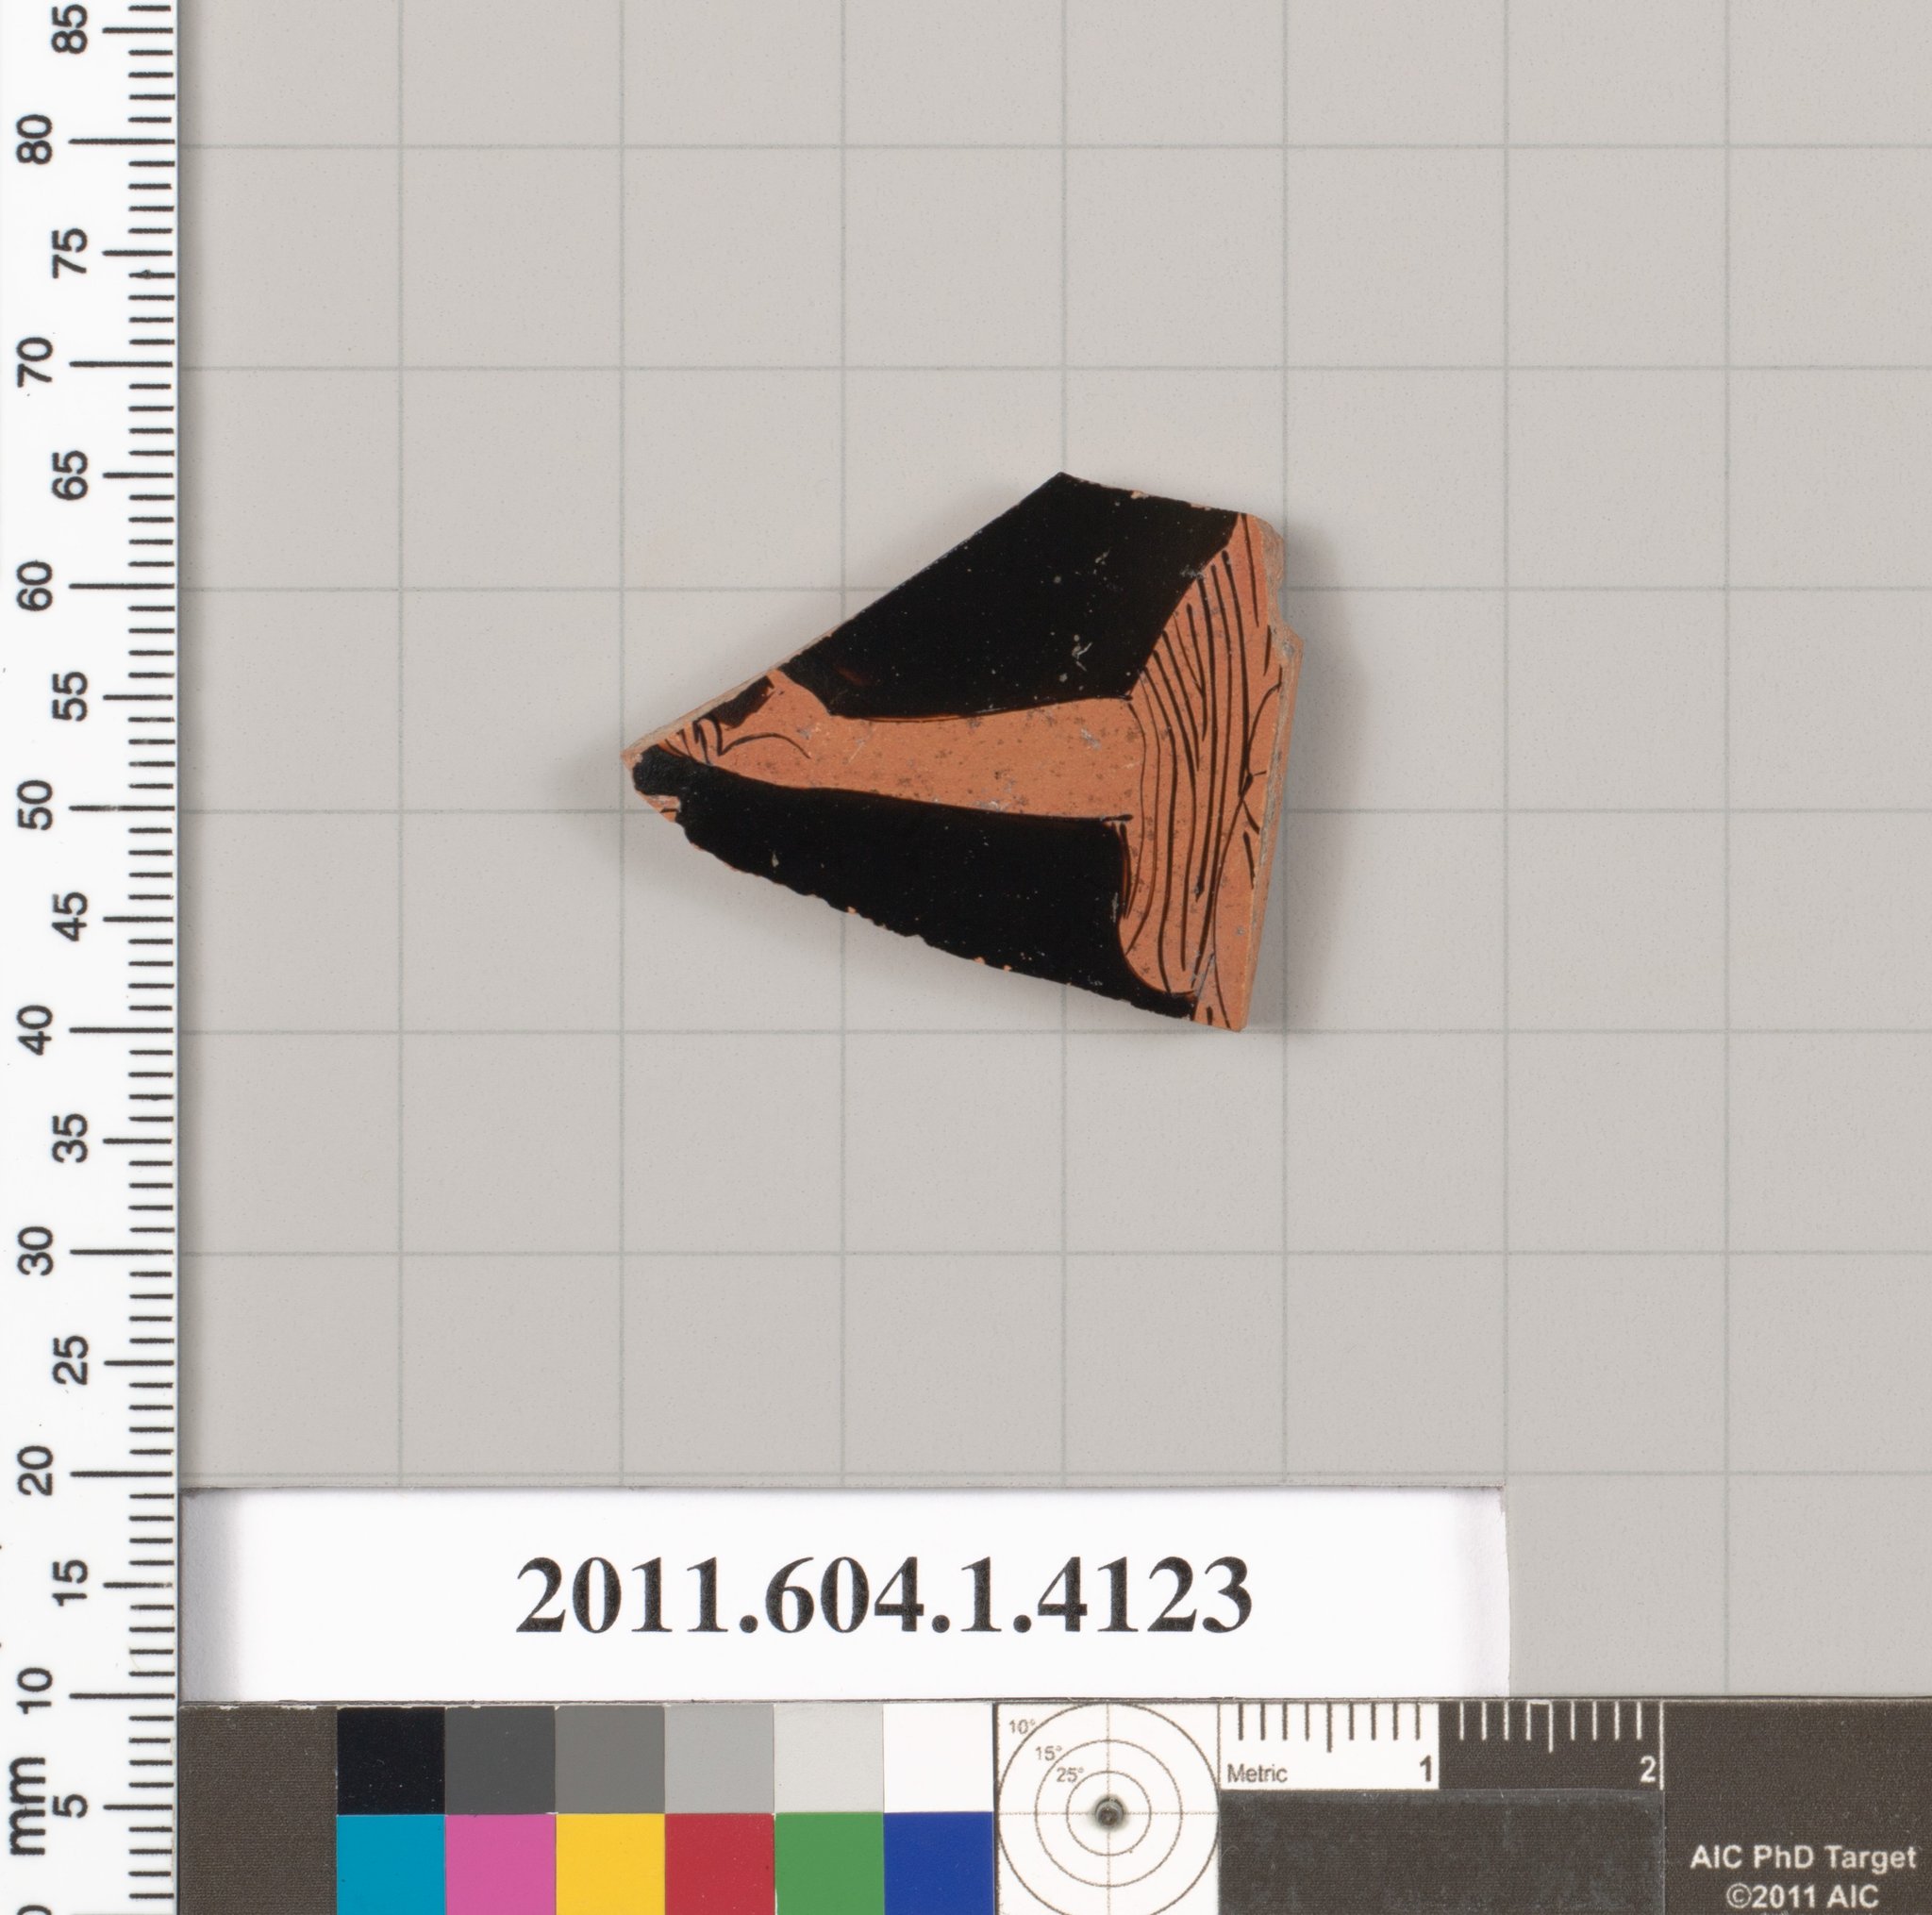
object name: kylix fragment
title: Terracotta fragment of a kylix (drinking cup)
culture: greek, attic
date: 490-480 BCE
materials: terracotta